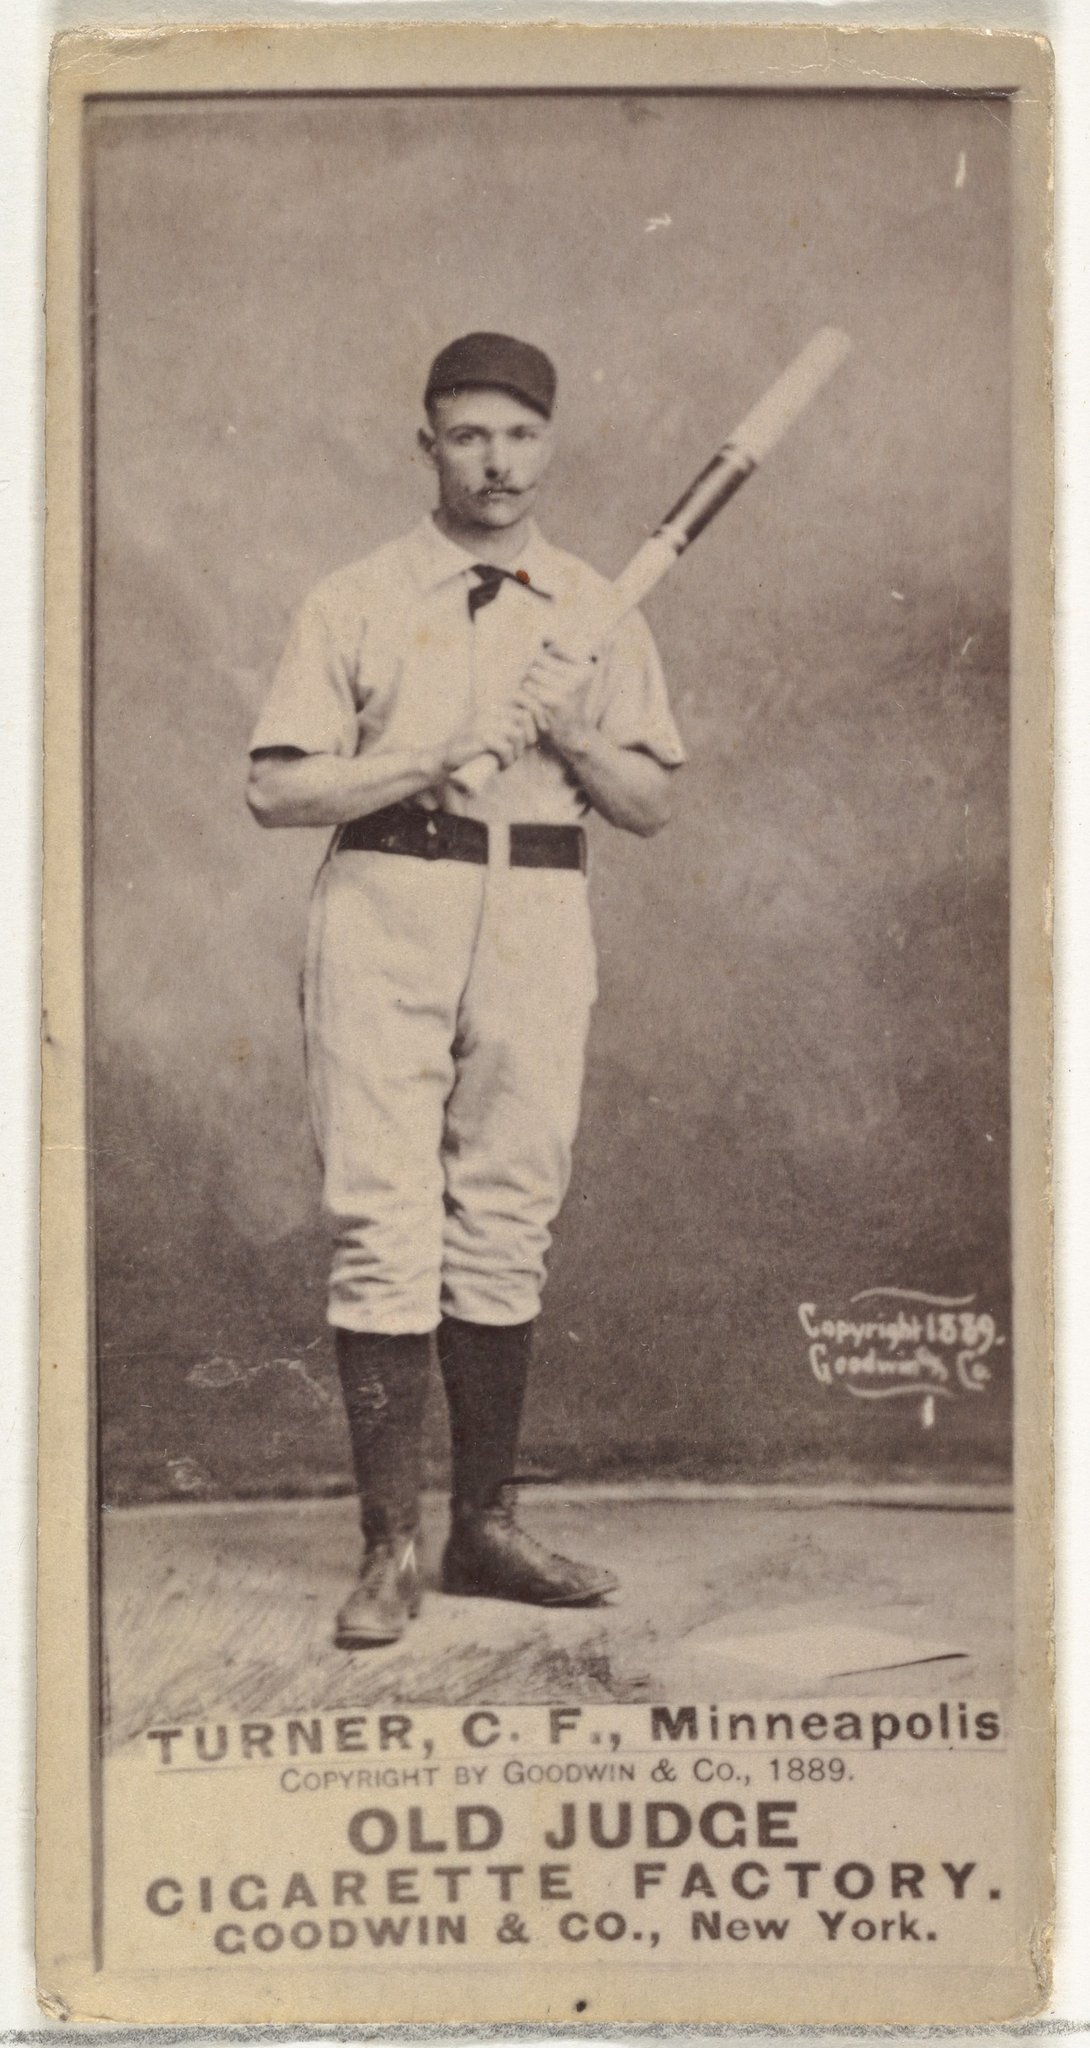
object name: baseball card, photograph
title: Thomas Turner, Center Field, Minneapolis, from the Old Judge series (N172) for Old Judge Cigarettes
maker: goodwin & company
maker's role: publisher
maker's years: 1850-1950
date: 1889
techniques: albumen silver print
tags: men,portraits,baseball,athletes